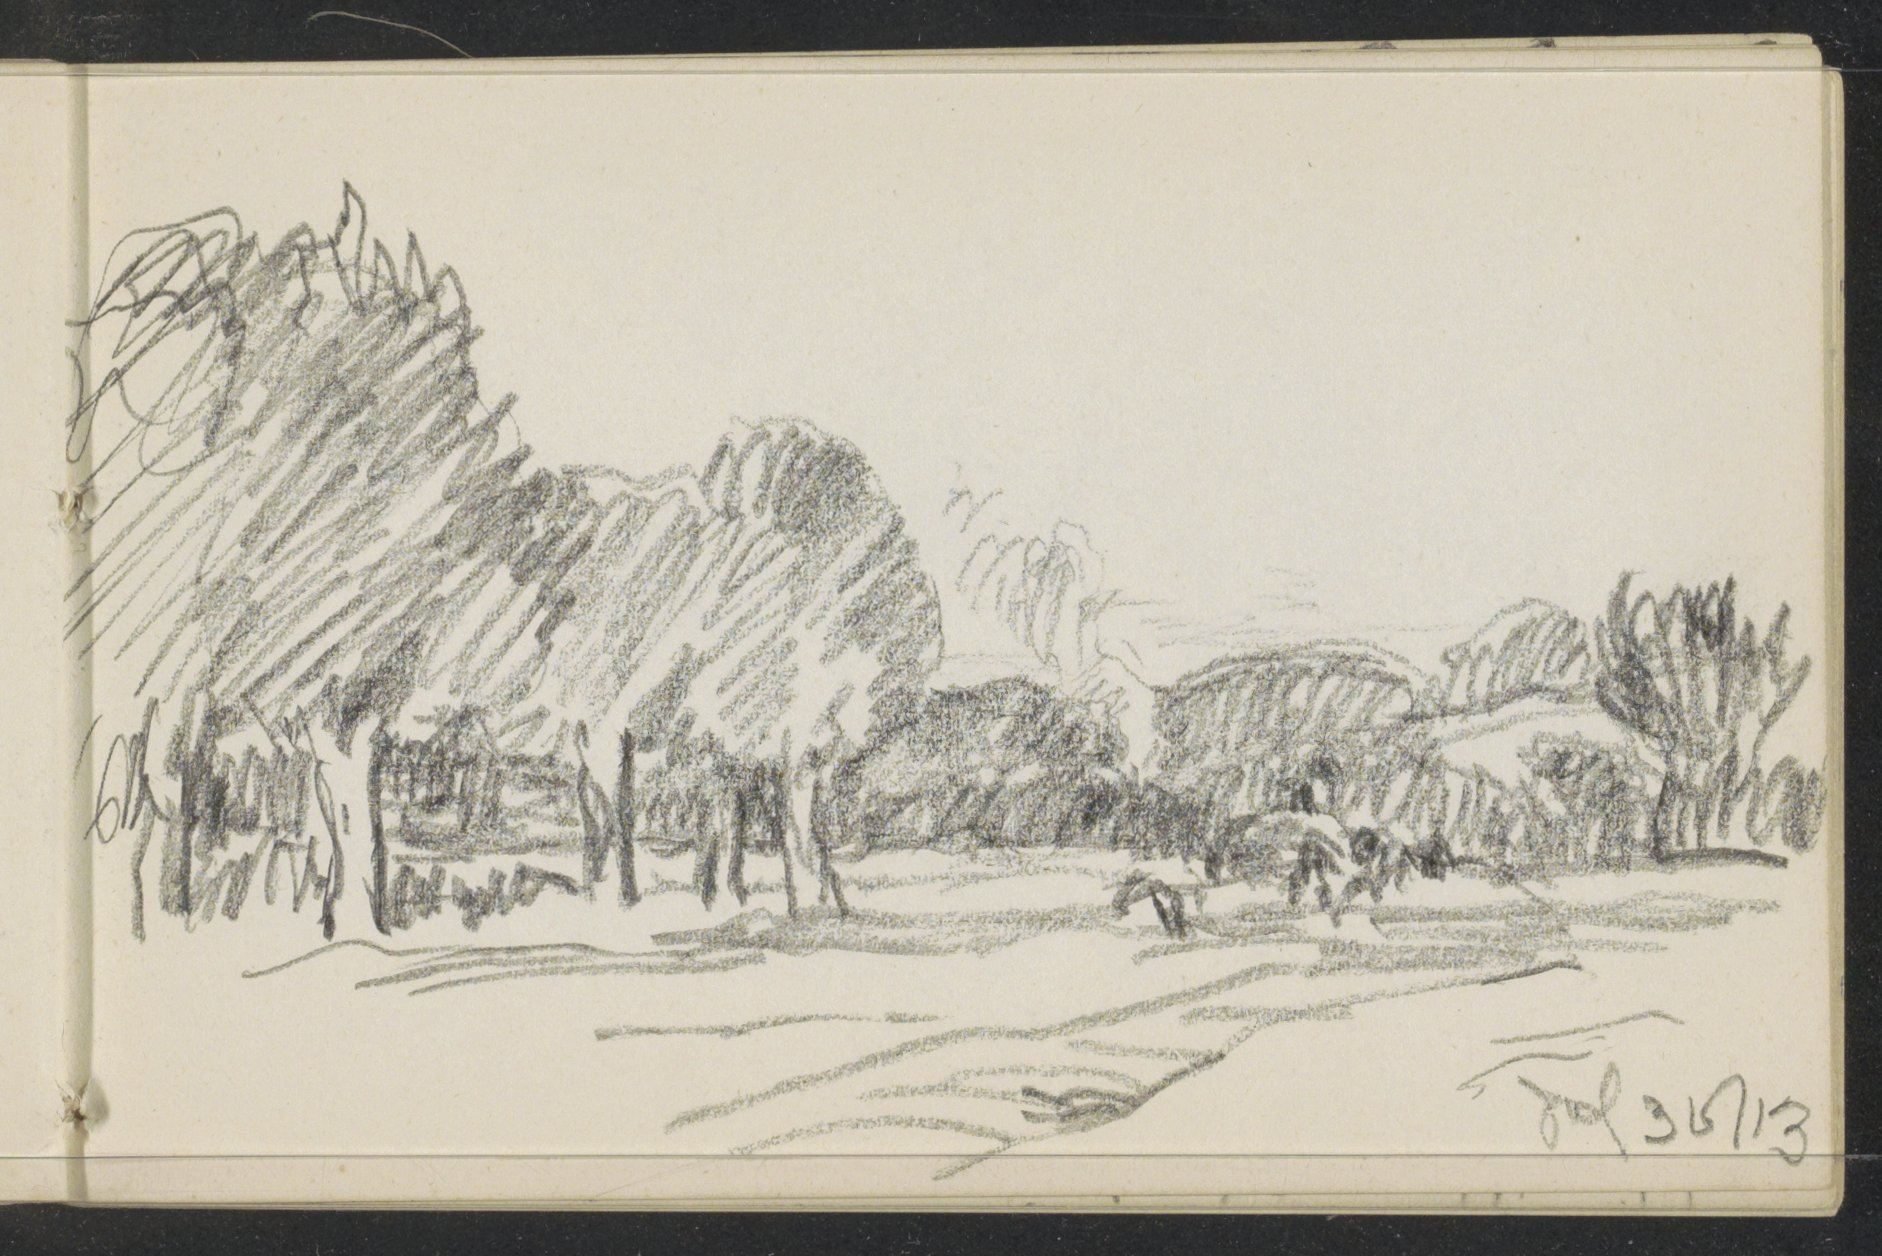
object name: sketchbook leaf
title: Landschap met bomen en figuren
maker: alexander shilling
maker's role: draughtsman, print maker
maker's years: 1859-1937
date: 1907-1913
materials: chalk, paper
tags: landscapes (+ landscape with figures, staffage)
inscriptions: date: ‘Jul 30/13’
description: Vermoedelijk zijn figuren aan het werk bij een hooiwagen. Blad 13 recto uit een schetsboek met 30 bladen.